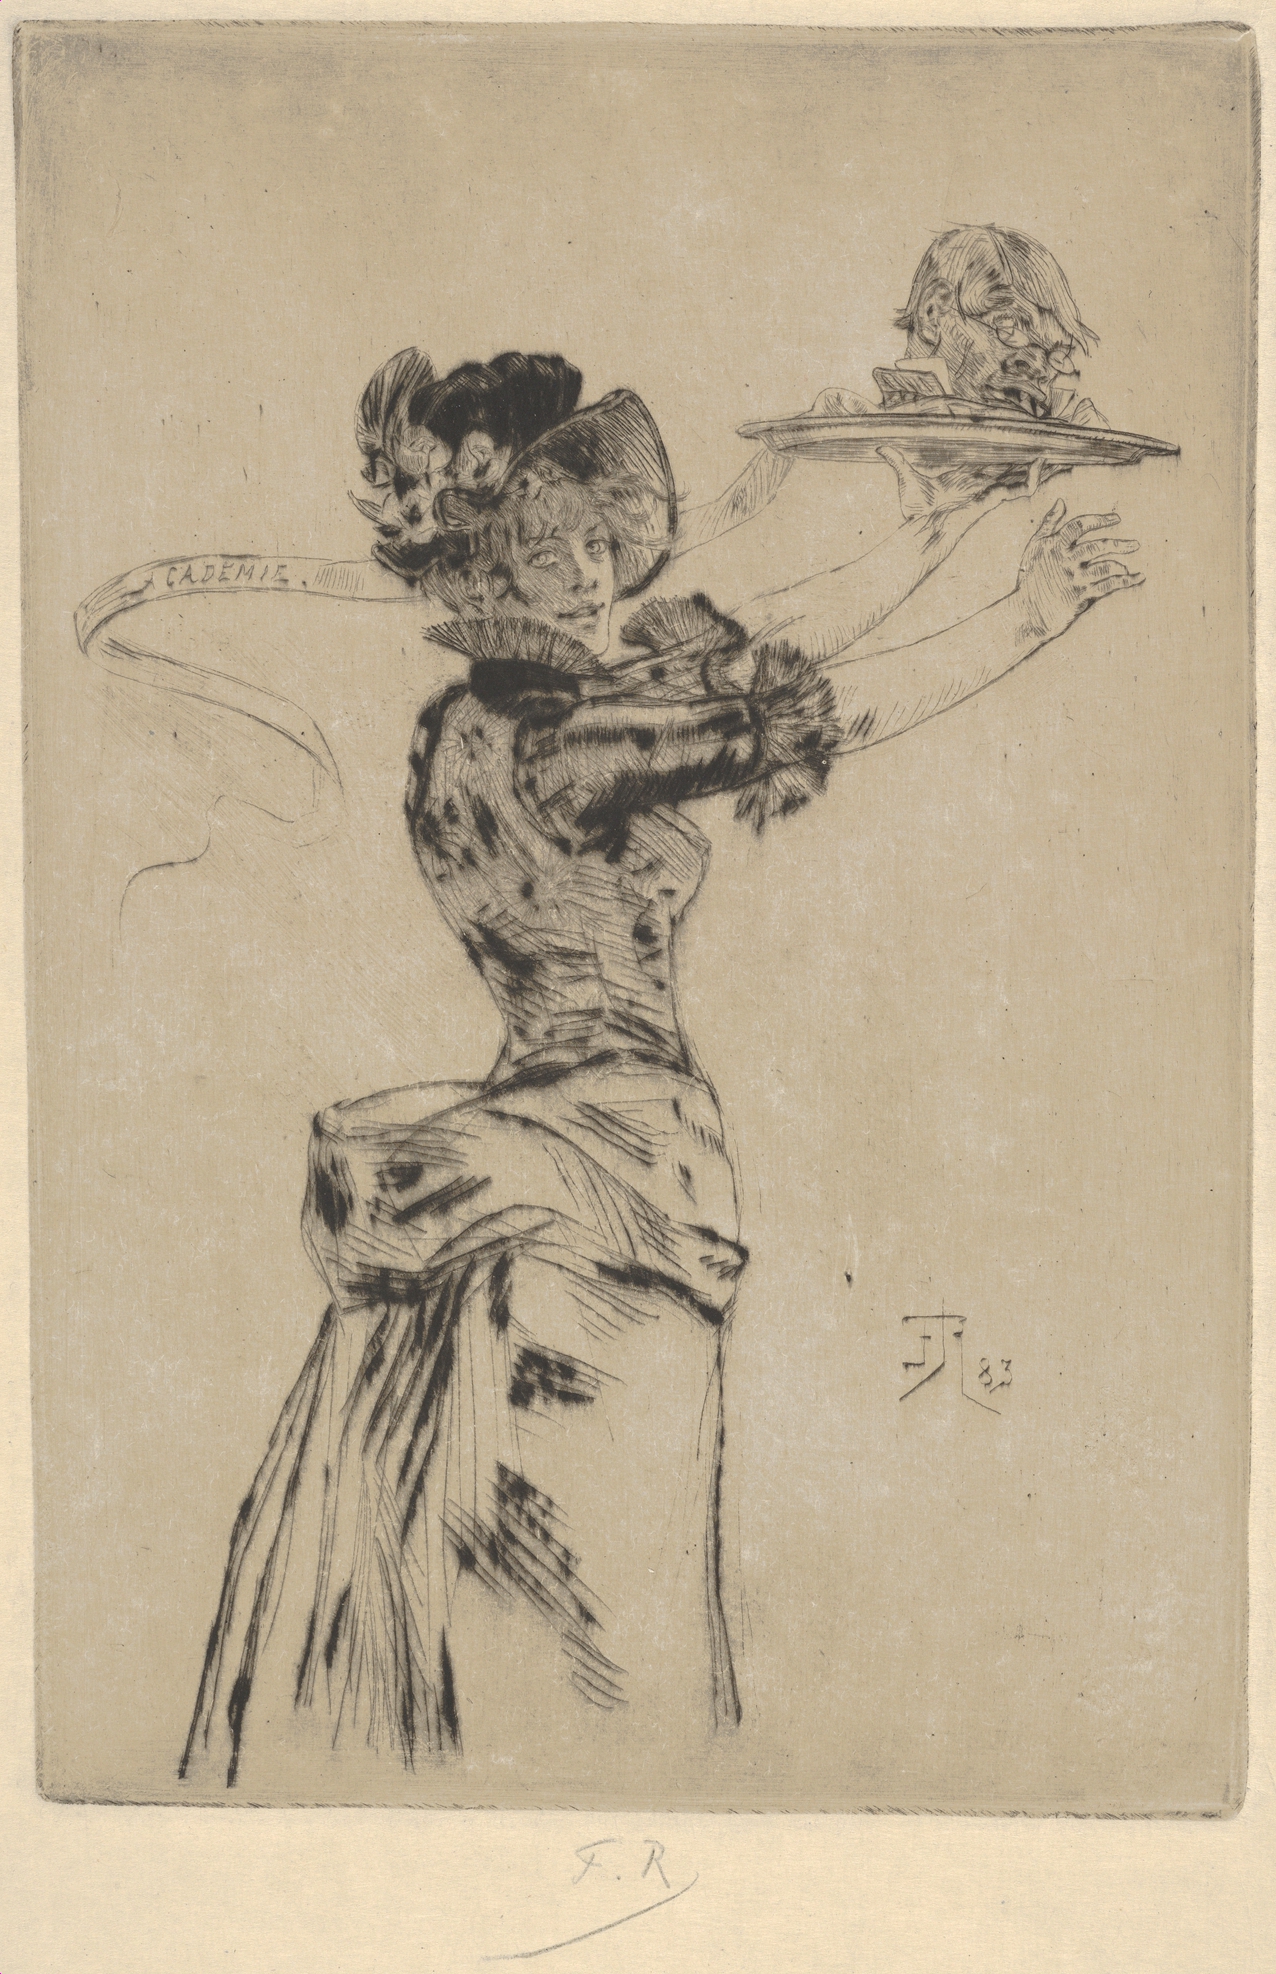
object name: print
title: Modernité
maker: félicien rops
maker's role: artist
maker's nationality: belgian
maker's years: 1833-1898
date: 1883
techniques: drypoint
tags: heads,women